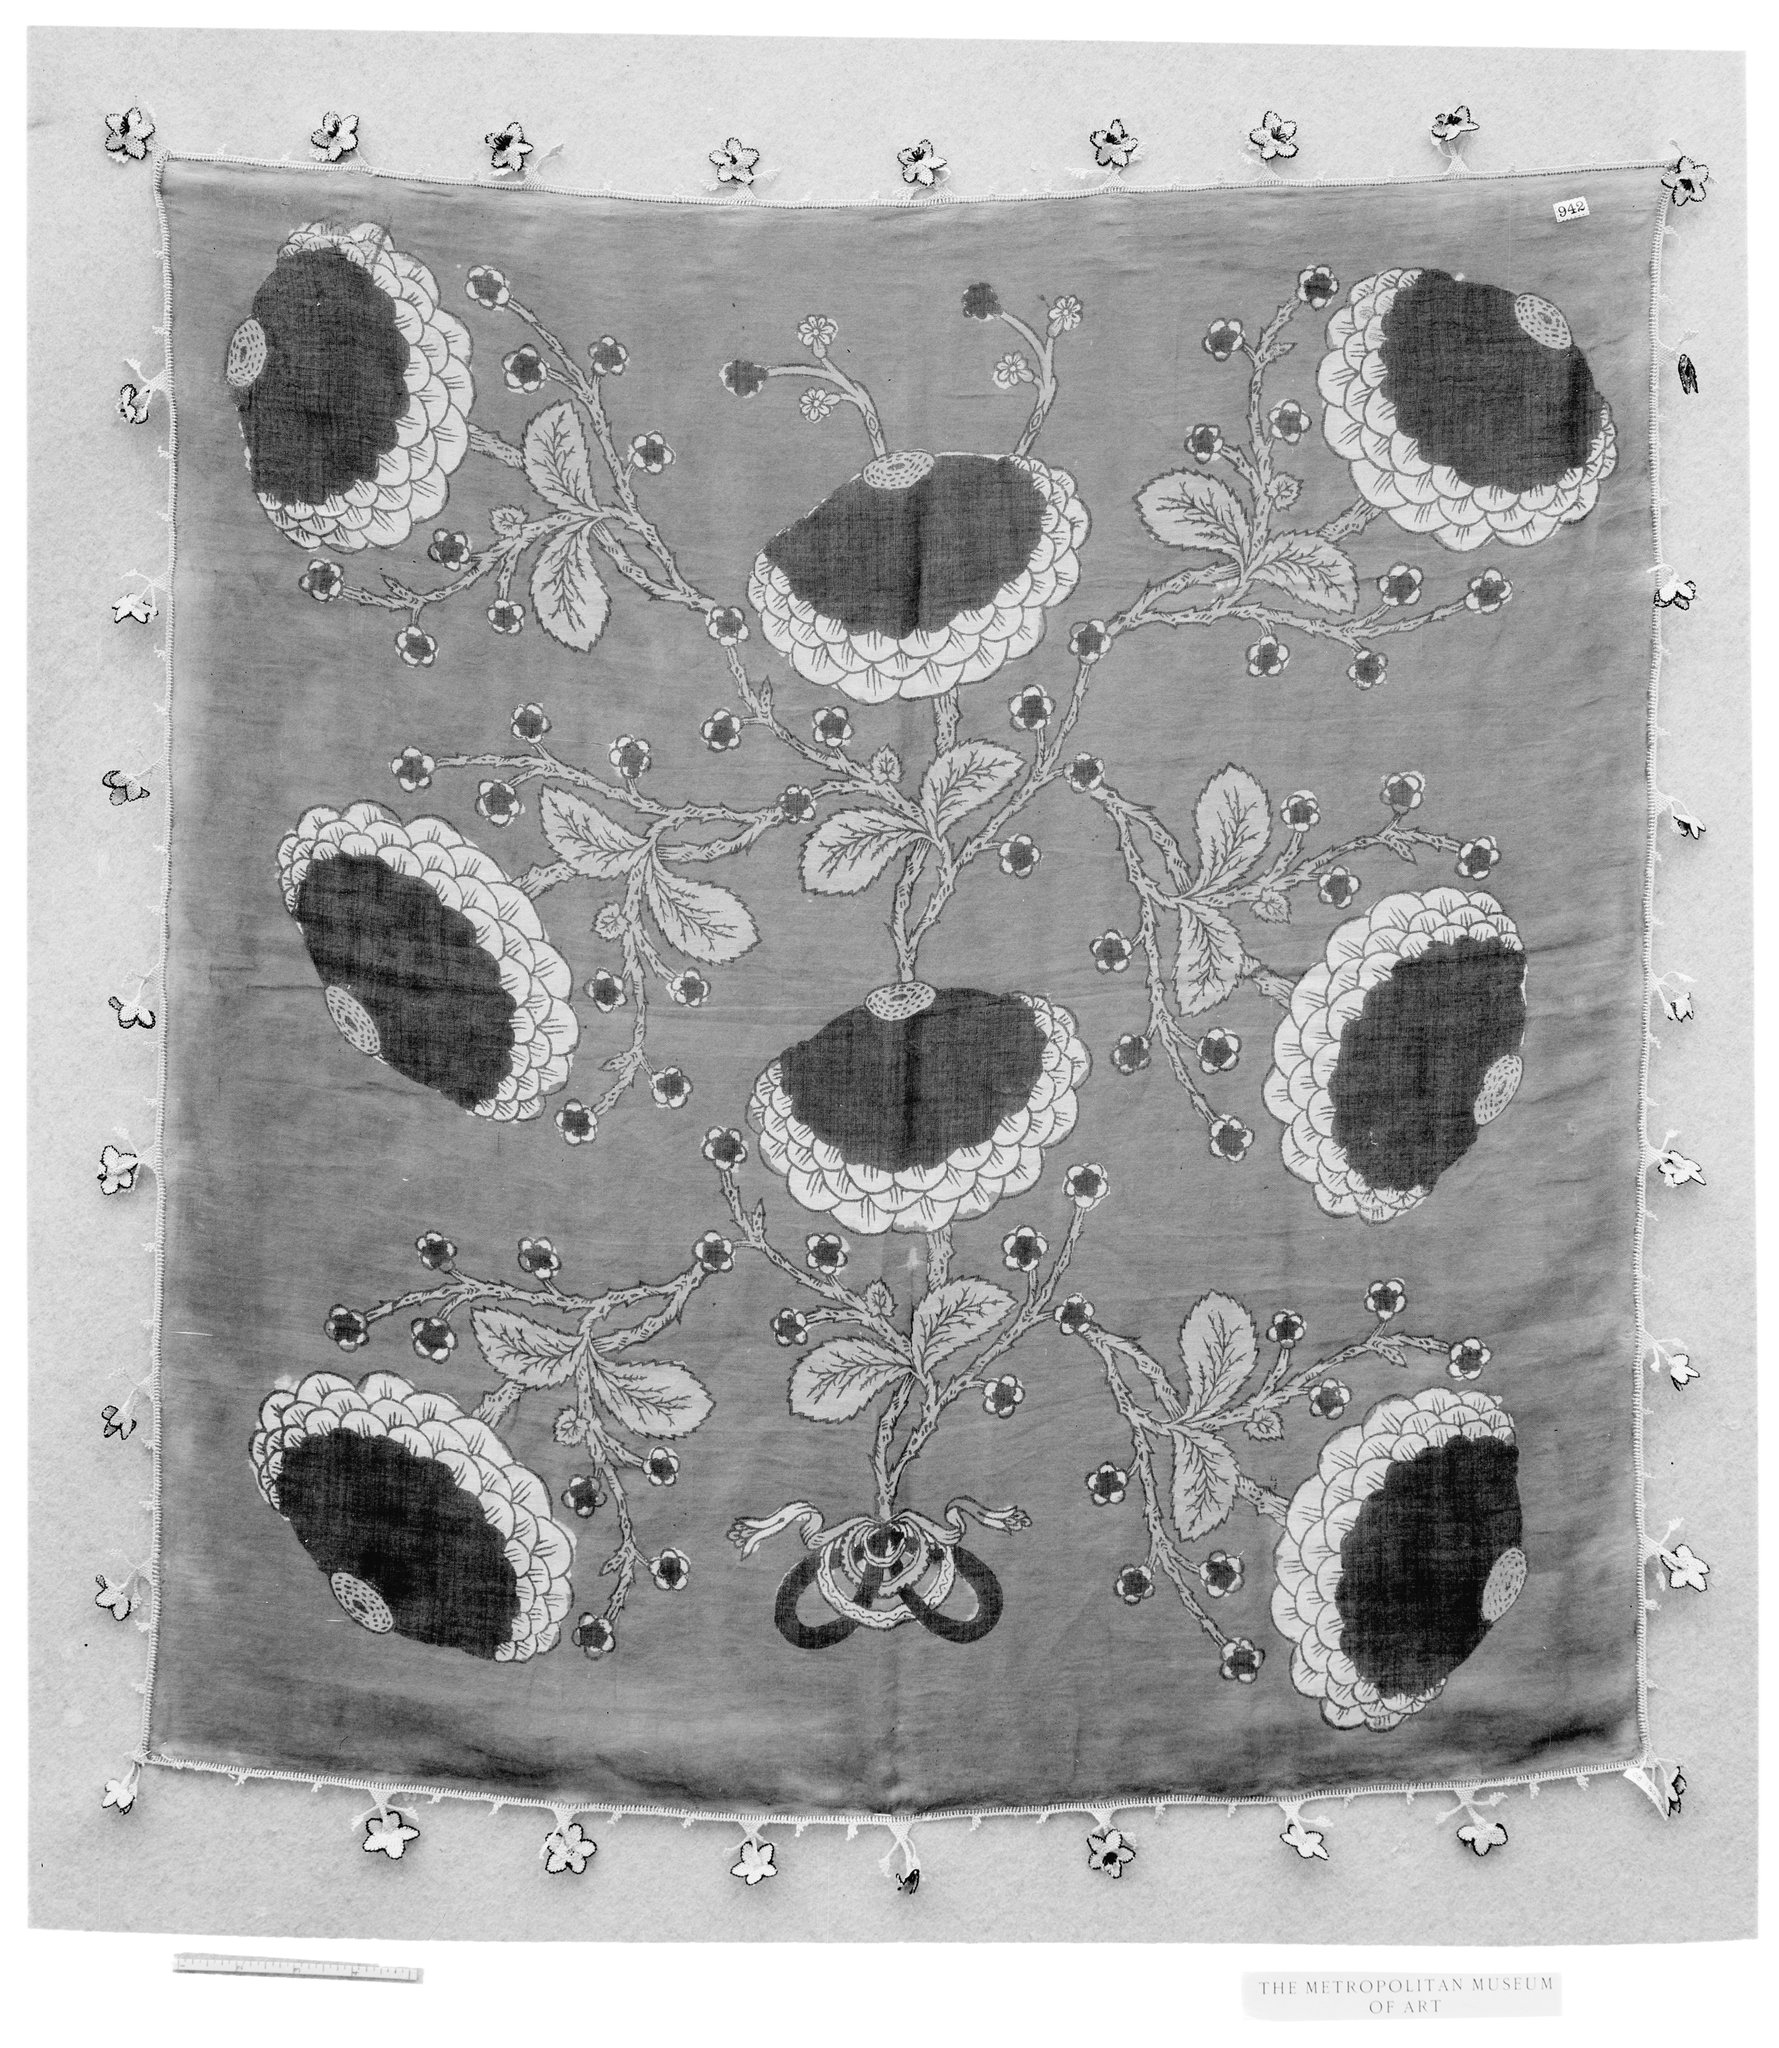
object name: cover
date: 1801-1900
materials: cotton, silk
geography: turkey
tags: flowers